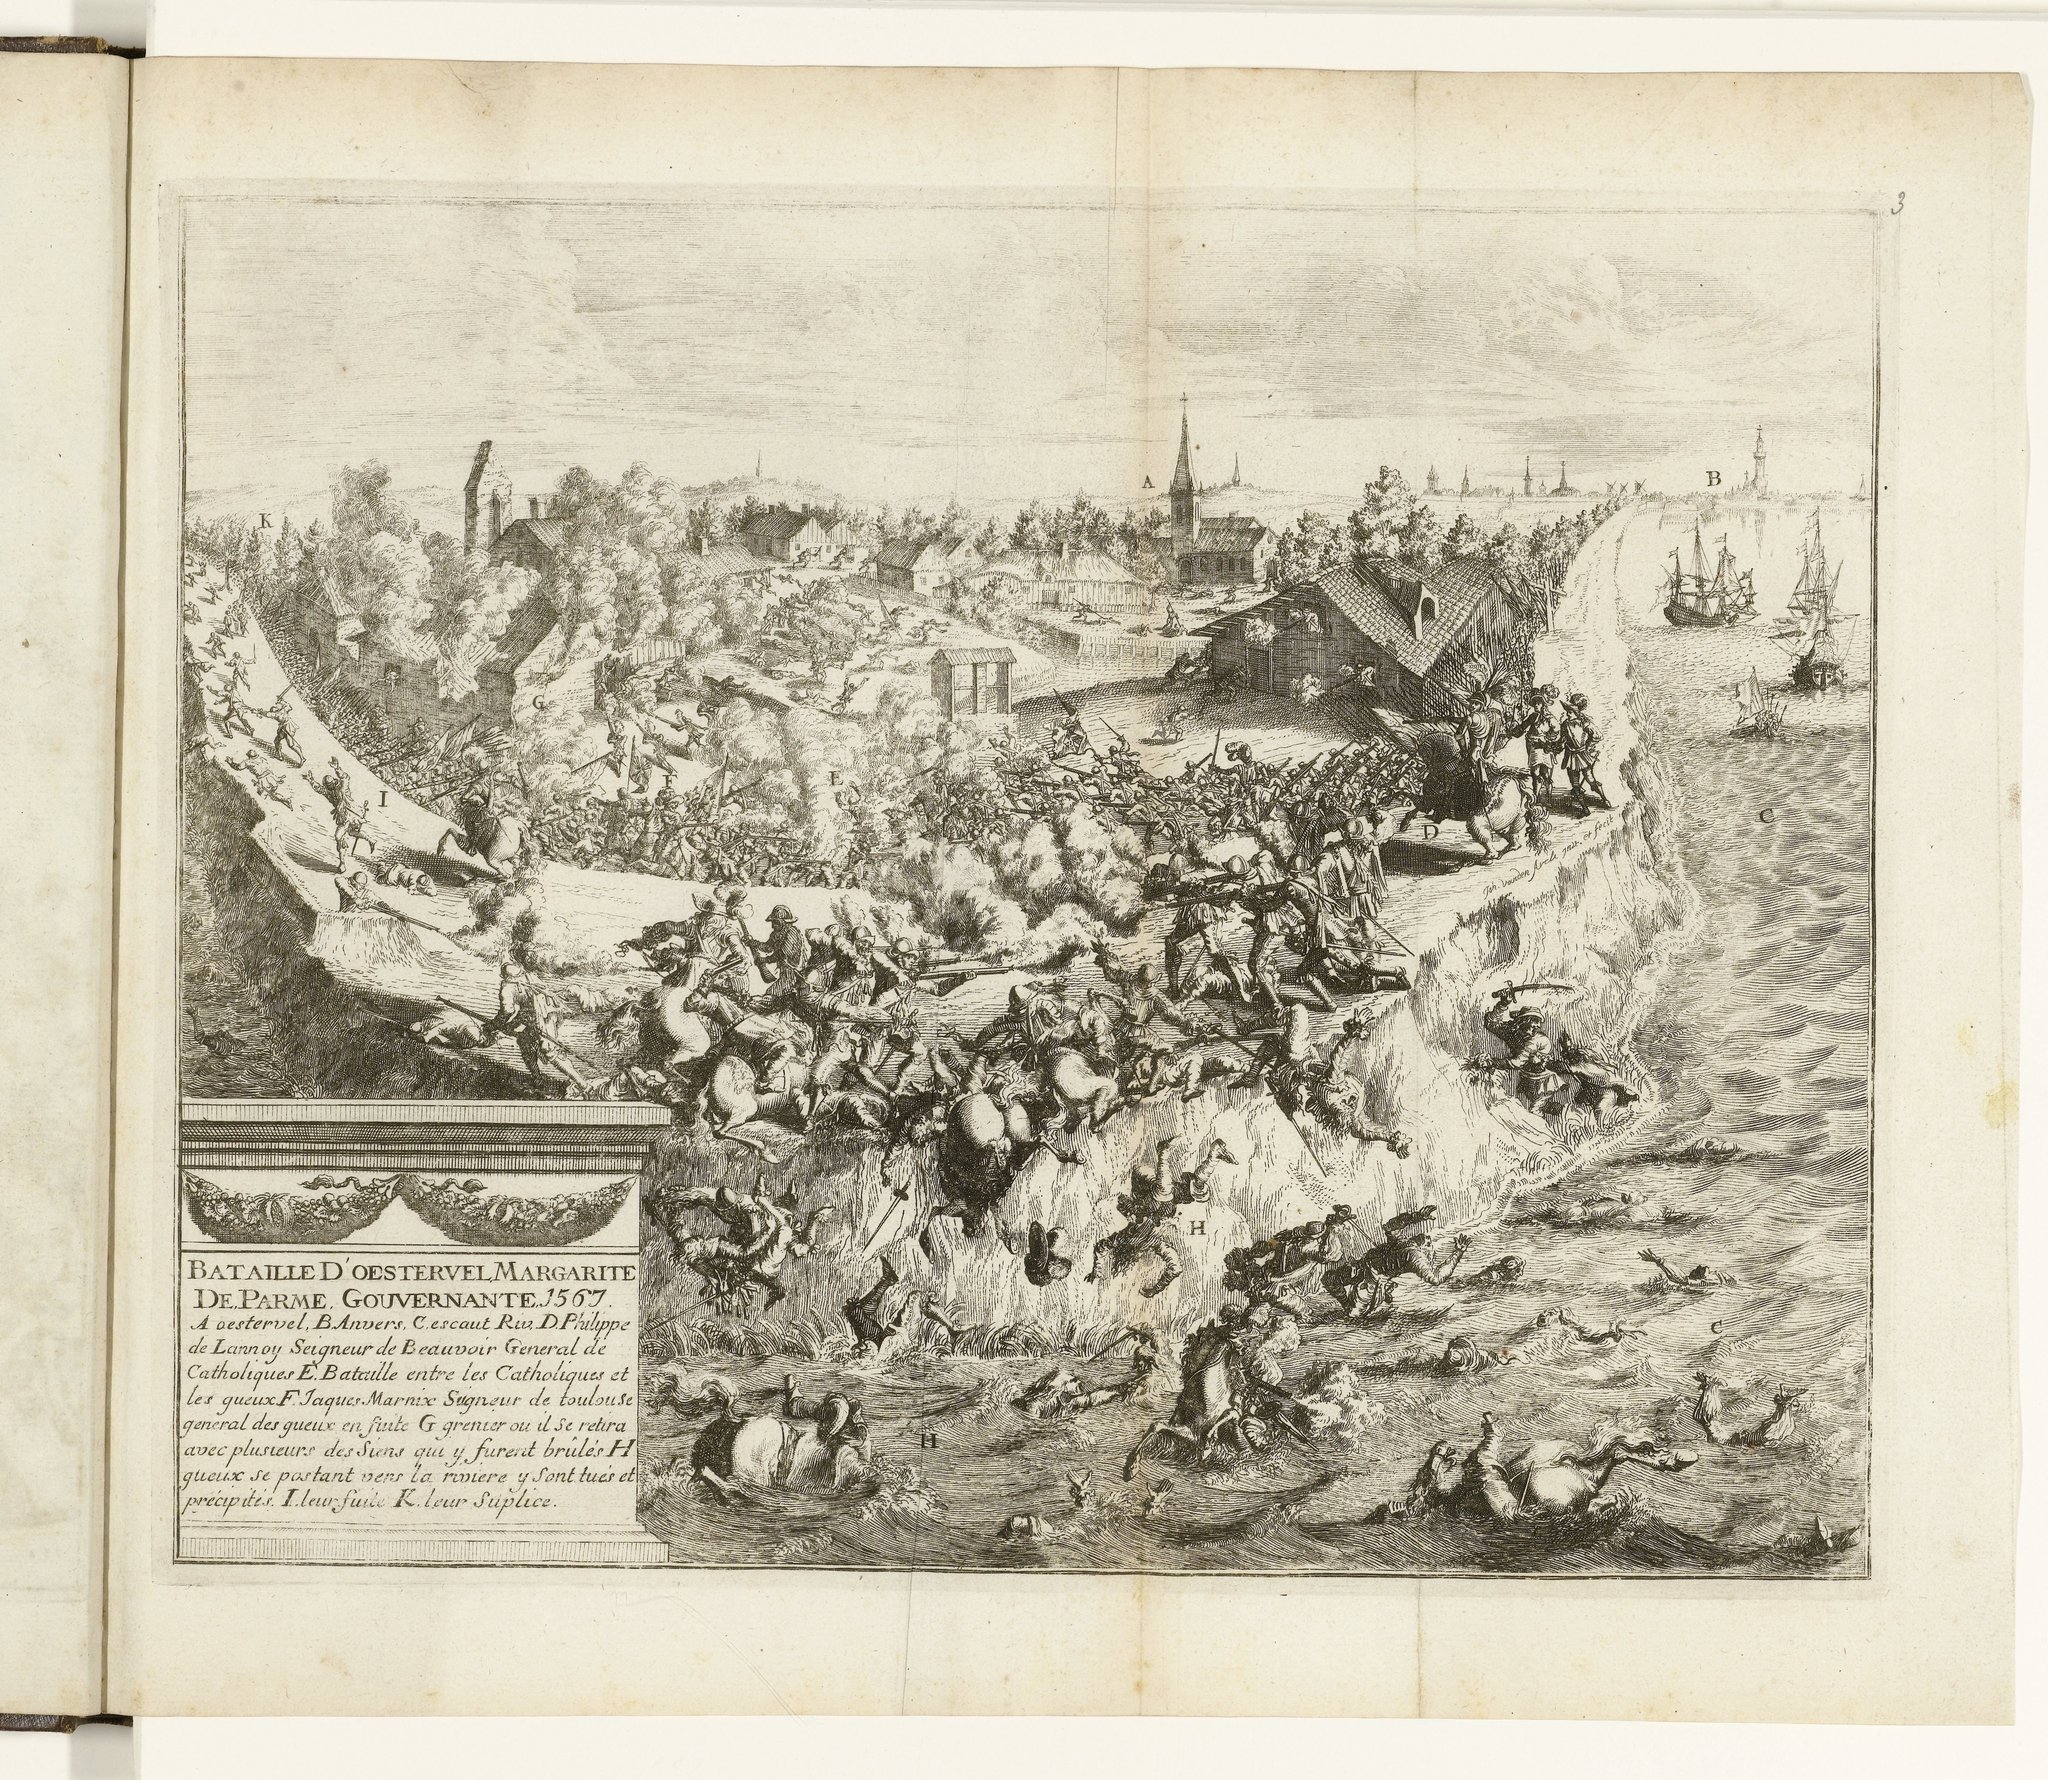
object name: history print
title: Bataille d'Oestervel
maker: johannes jacobsz van den aveele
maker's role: print maker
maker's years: 1655-1727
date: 1665-1727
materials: paper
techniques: etching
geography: netherlands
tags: battle, fighting in general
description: Waarschijnlijk oorspronkelijk vervaardigd voor een uitgave van Histoire de la guerre de Flandre, van F. Strada, eind 17e eeuw. De prent is onderdeel van een bundel van prenten en portretten getiteld Des Guerres de Flandres, in drie delen, met in totaal 22 batailles, 6 portretten en 3 titelprenten voor de afzonderlijke delen, alles (behalve de portretten) door De Hooghe en Ledesma in één band, ongenummerd en zonder titelblad (zie Rijksmuseum Research Library, inv.nr. BI-1929-10, 329 C 20). De prenten hebben betrekking op de periode 1567-1592.